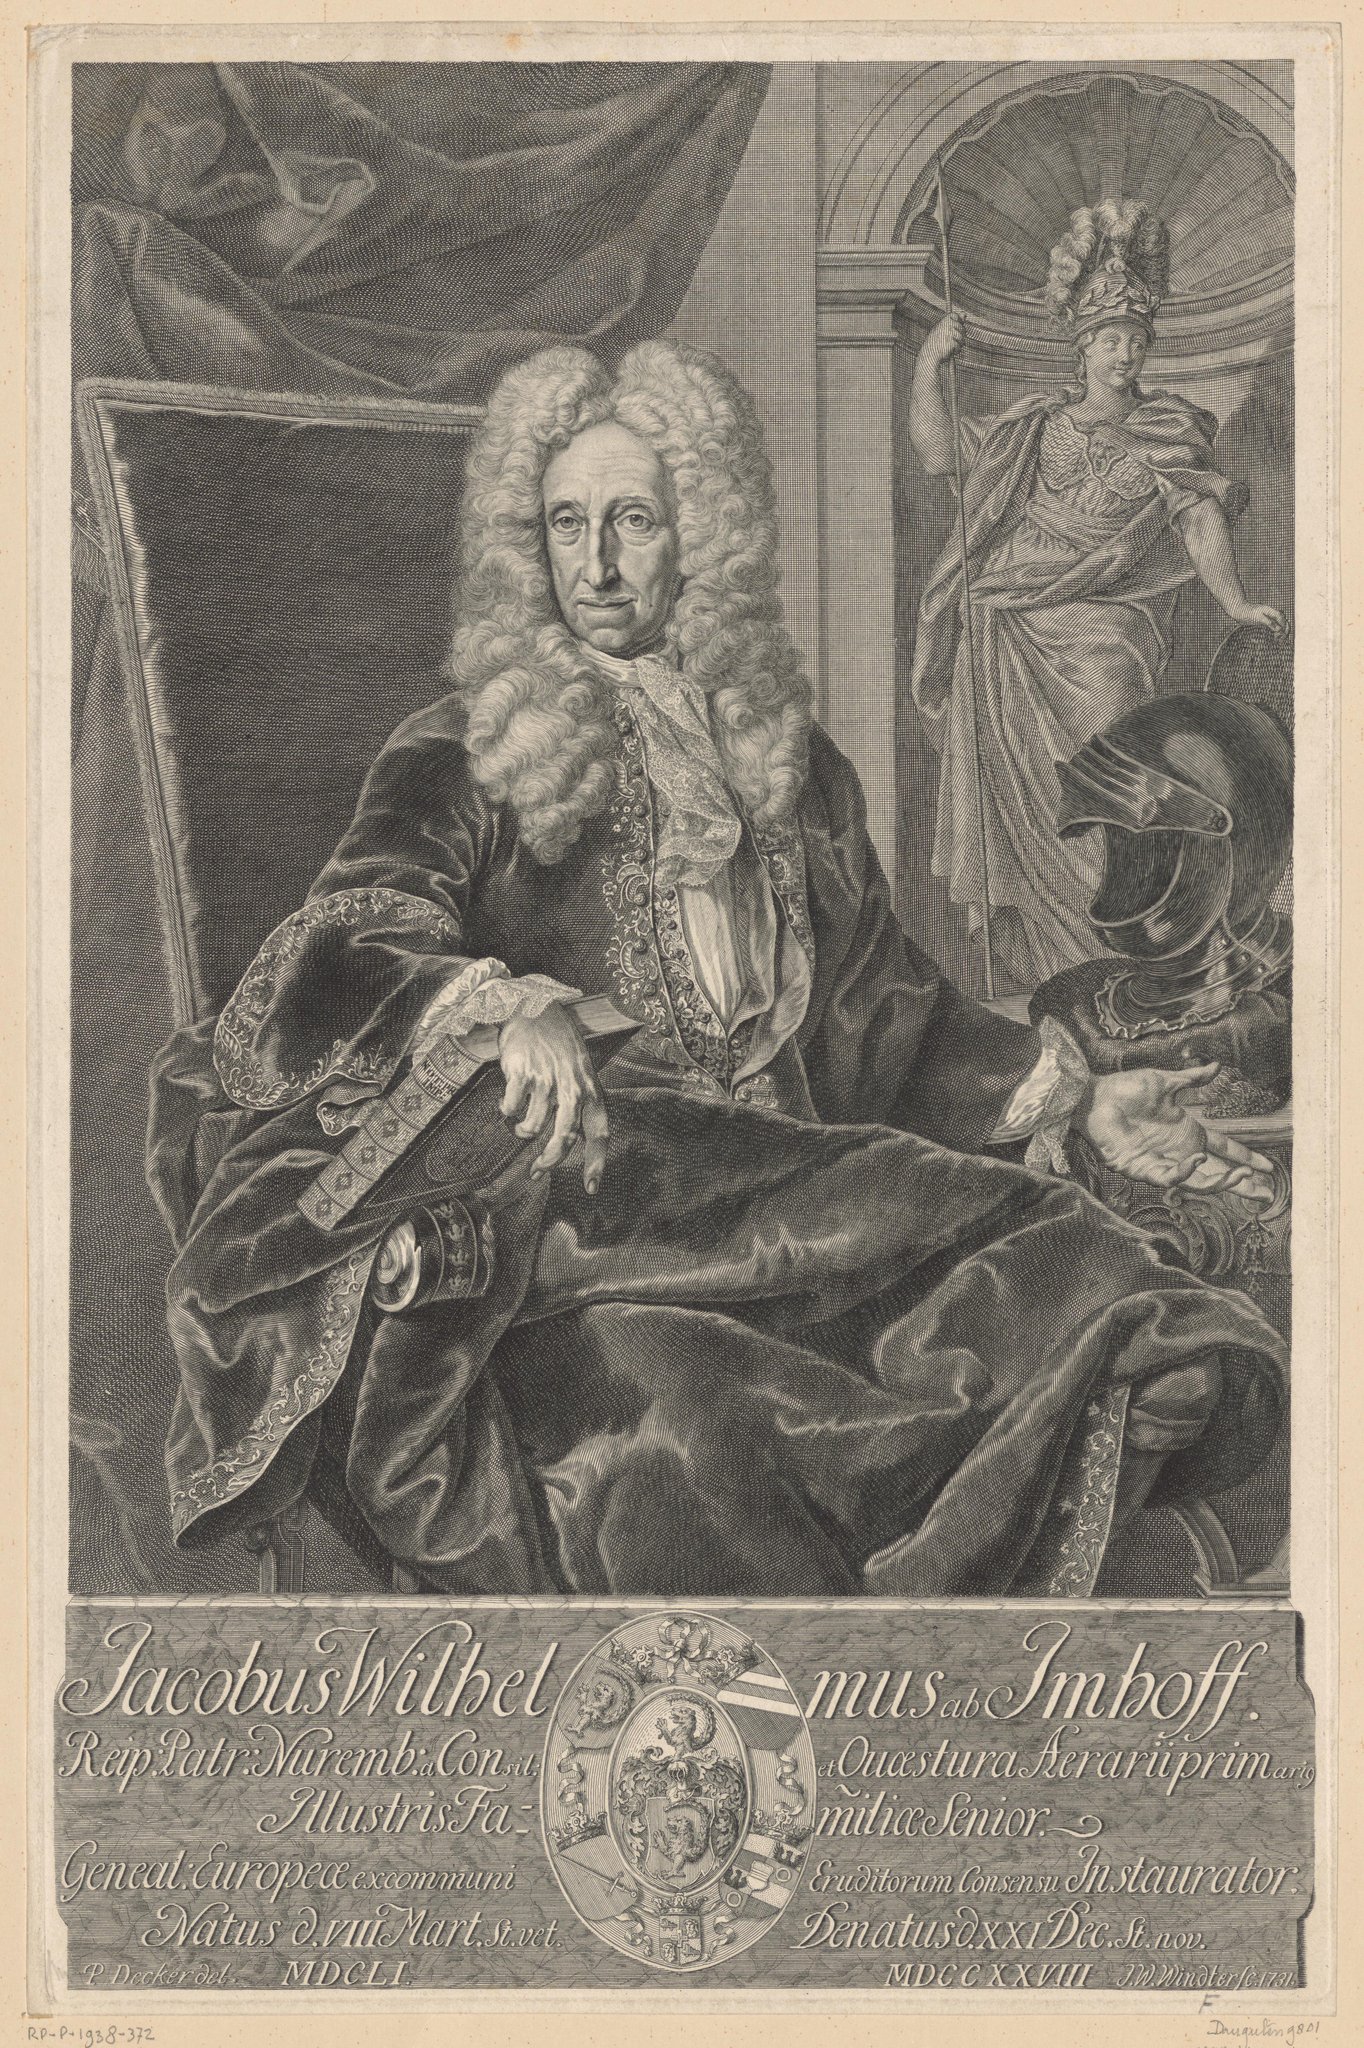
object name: print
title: Portret van Jacobus Wilk van Imhoff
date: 1731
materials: paper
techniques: engraving, etching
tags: helmet, historical persons, book, piece of sculpture, reproduction of a piece of sculpture, sitting on an elevation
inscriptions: collector's mark: Lugt 2228